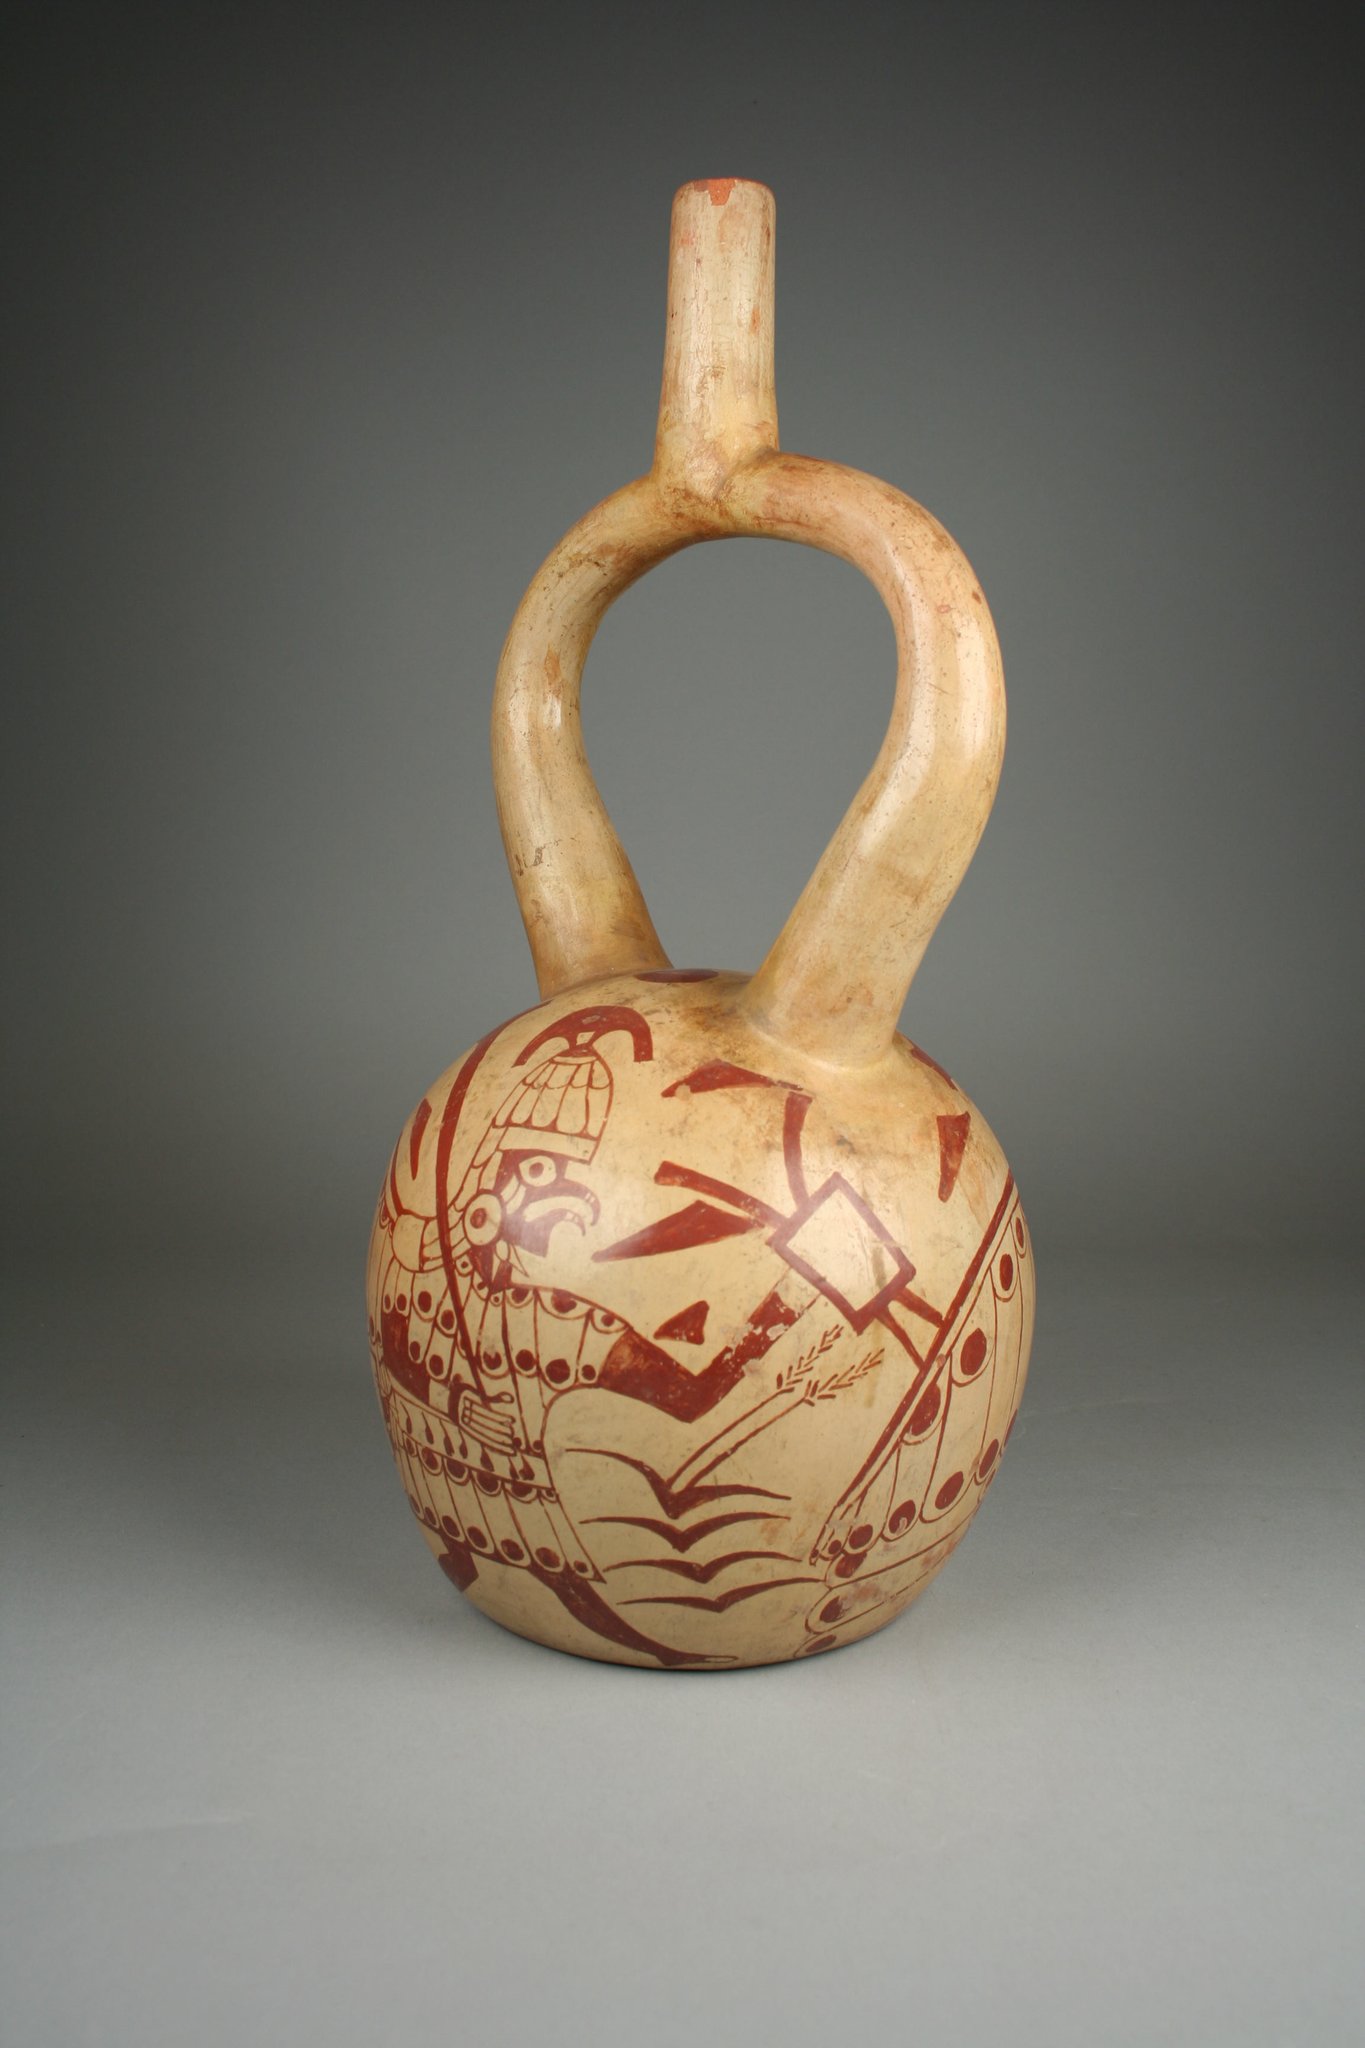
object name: bottle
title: Bird Warrior Bottle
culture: moche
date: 301-700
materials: ceramic, pigment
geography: peru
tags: birds,warriors